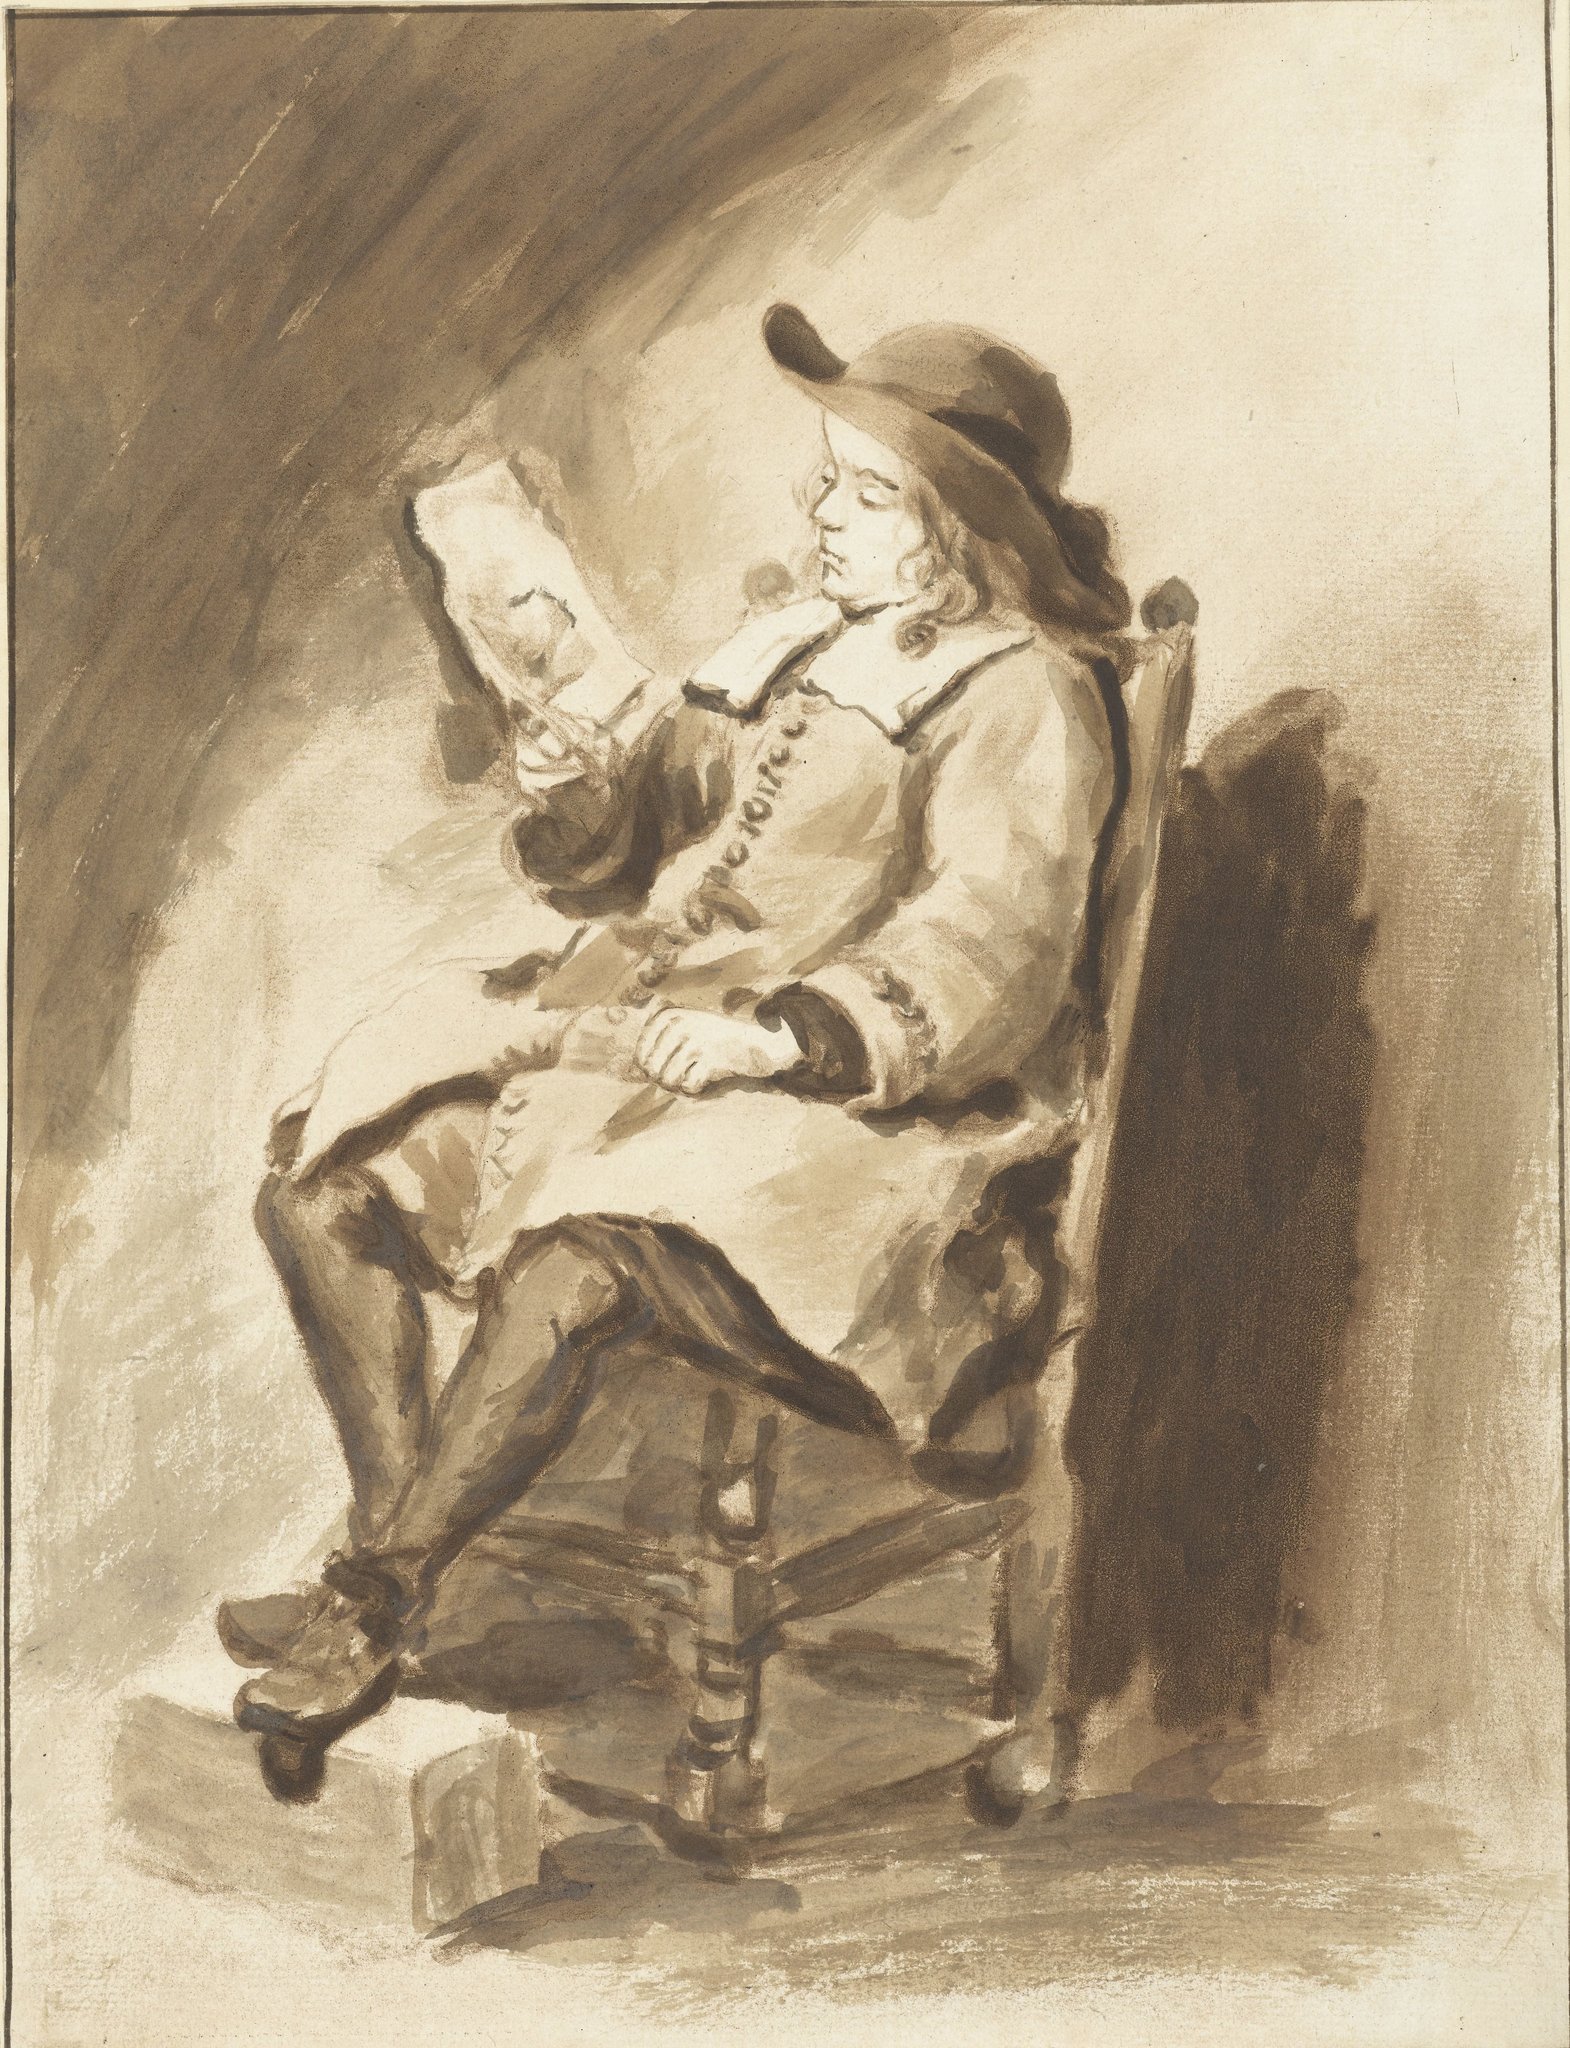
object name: print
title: Lezende jongeling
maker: jurriaan cootwijck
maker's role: print maker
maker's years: 1714-1798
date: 1724-1798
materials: paper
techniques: print drawing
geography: amsterdam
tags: reading, youth, adolescent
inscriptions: collector's mark: Lugt 2228, collector's mark: Lugt 2725, collector's mark: Lugt 2760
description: Een jongeling in een leunstoel leest een blad papier.